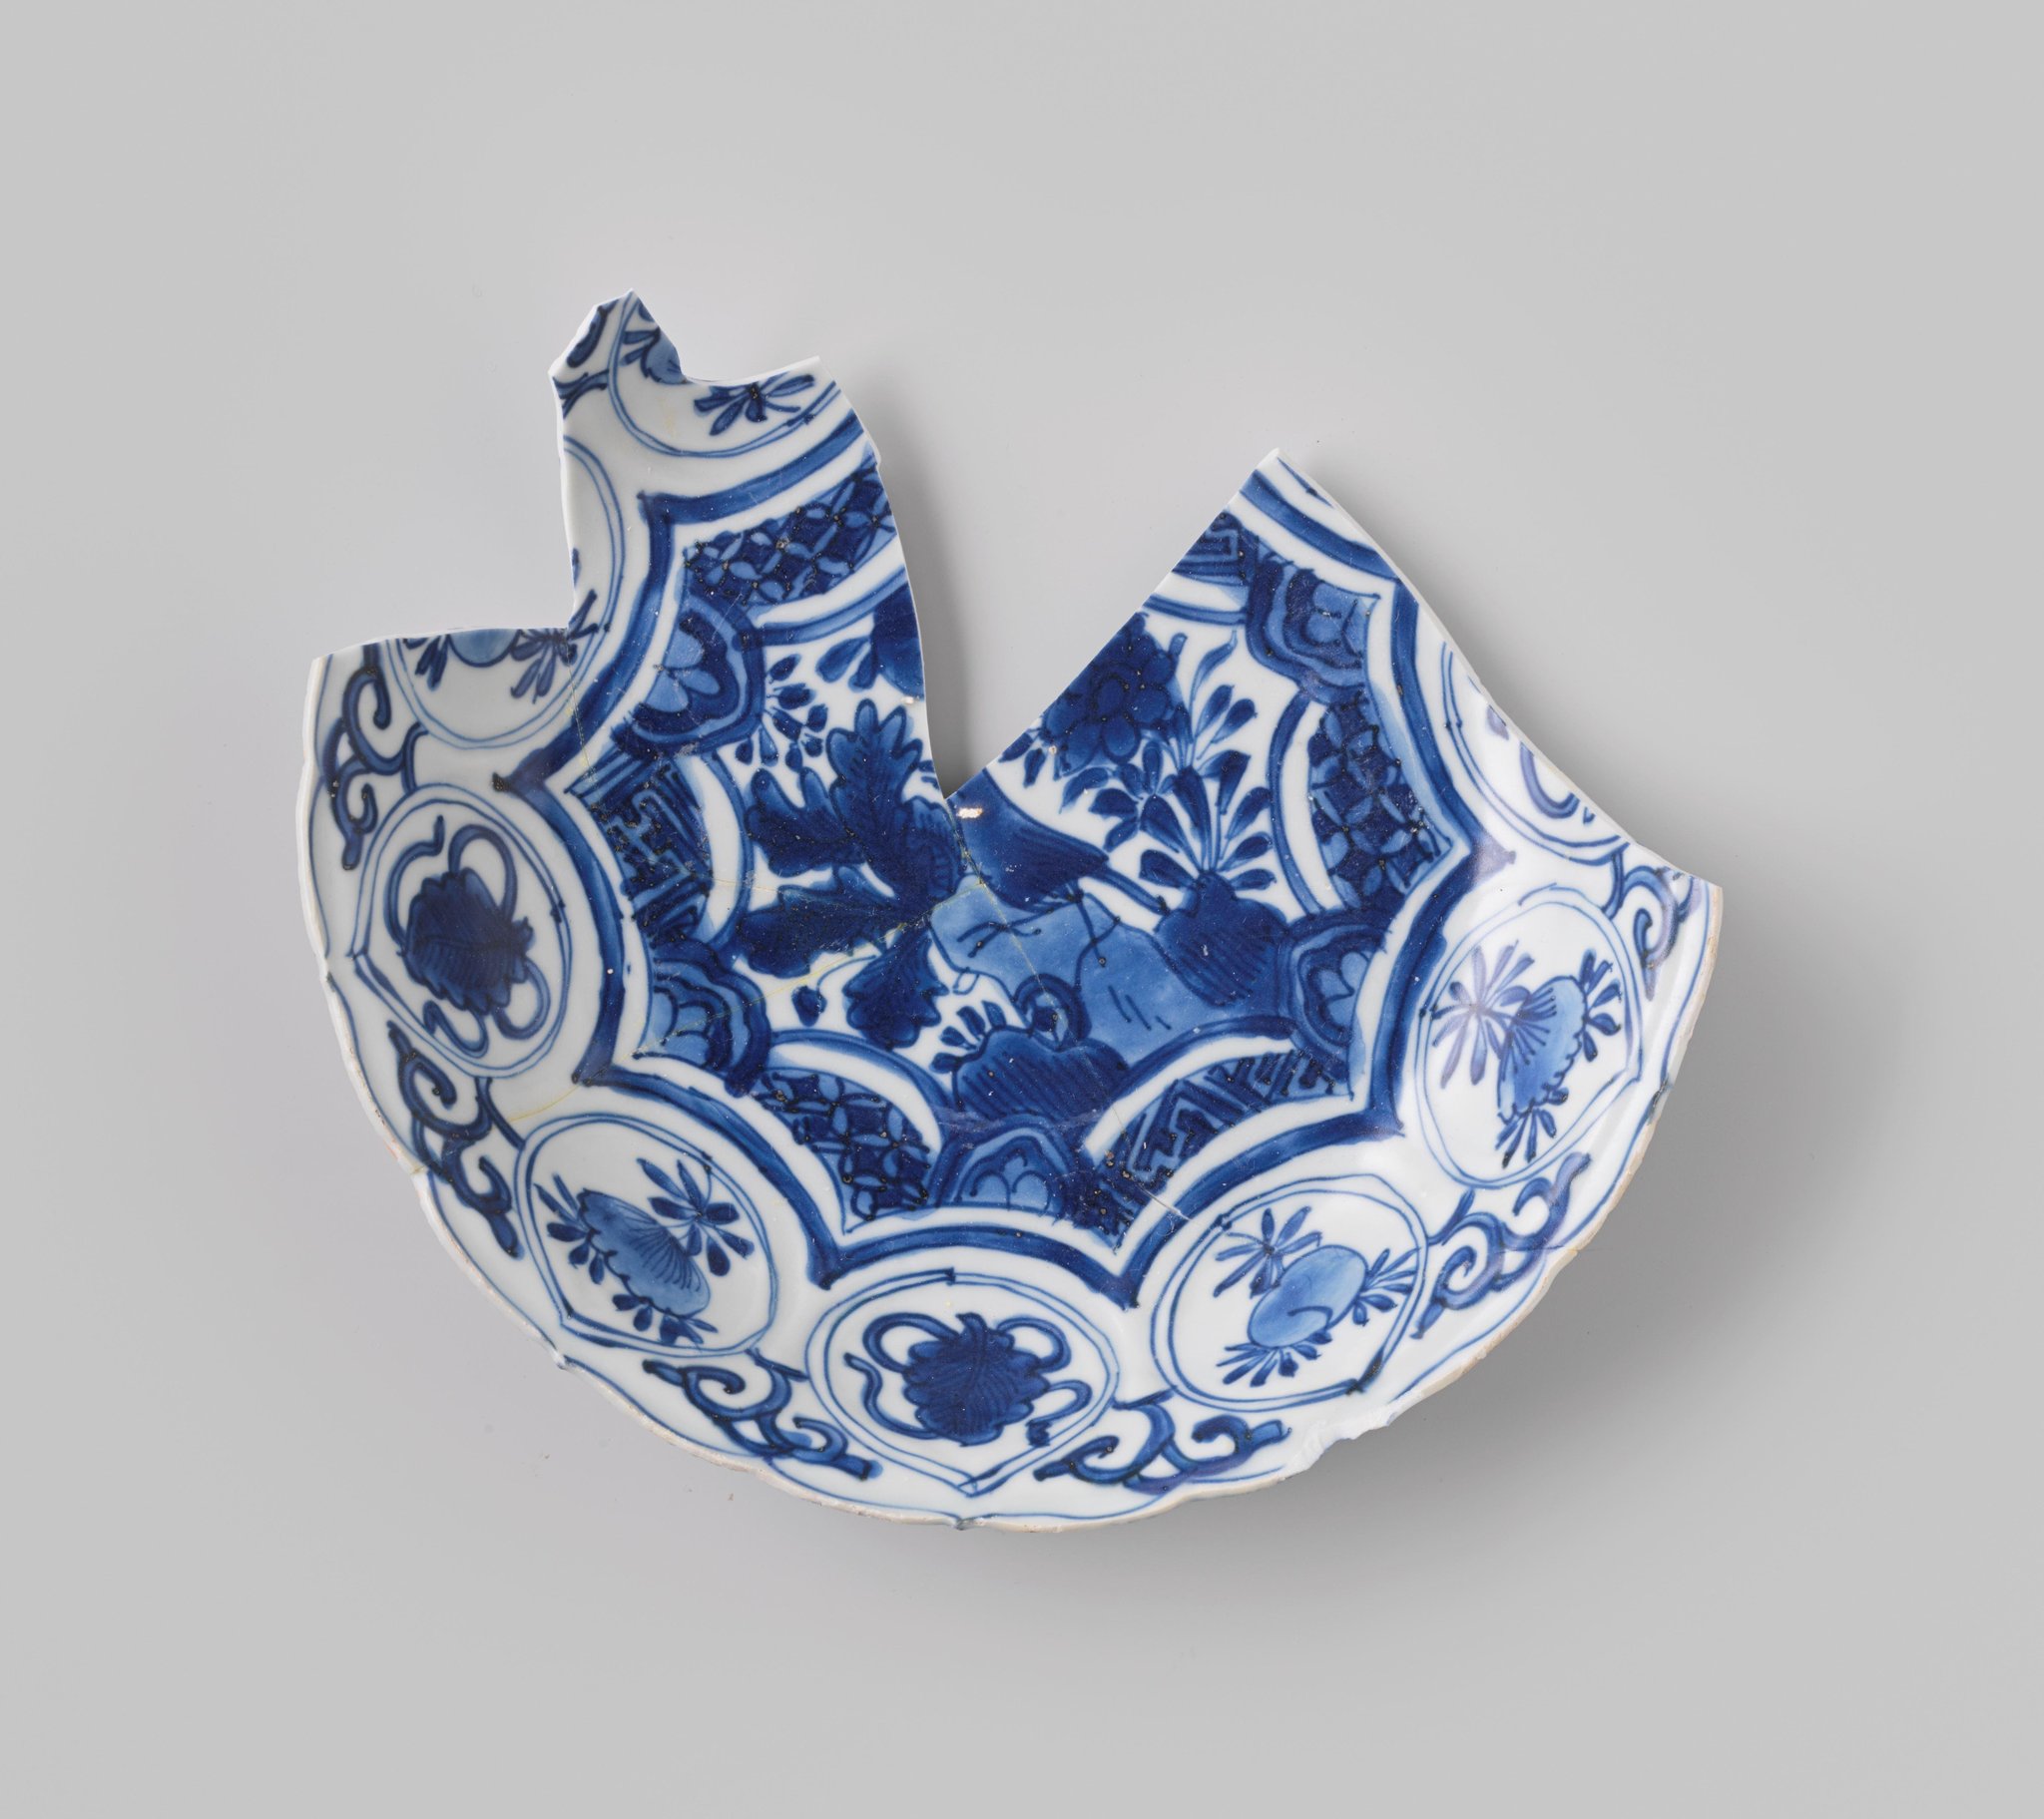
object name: plate dish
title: Bord uit V.O.C.-schip de 'Witte leeuw'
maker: Anonymous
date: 1613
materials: bone china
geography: jingdezhen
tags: verenigde oostindische compagnie, sint-helena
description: A dish without a flattened rim. A star-shaped medallion with 6 rui heads within a star-shaped medallion with various diaper patterns. A central decoration of a bird on a rock and a flower. The medallions decorated alternately with a peach and a symbol.